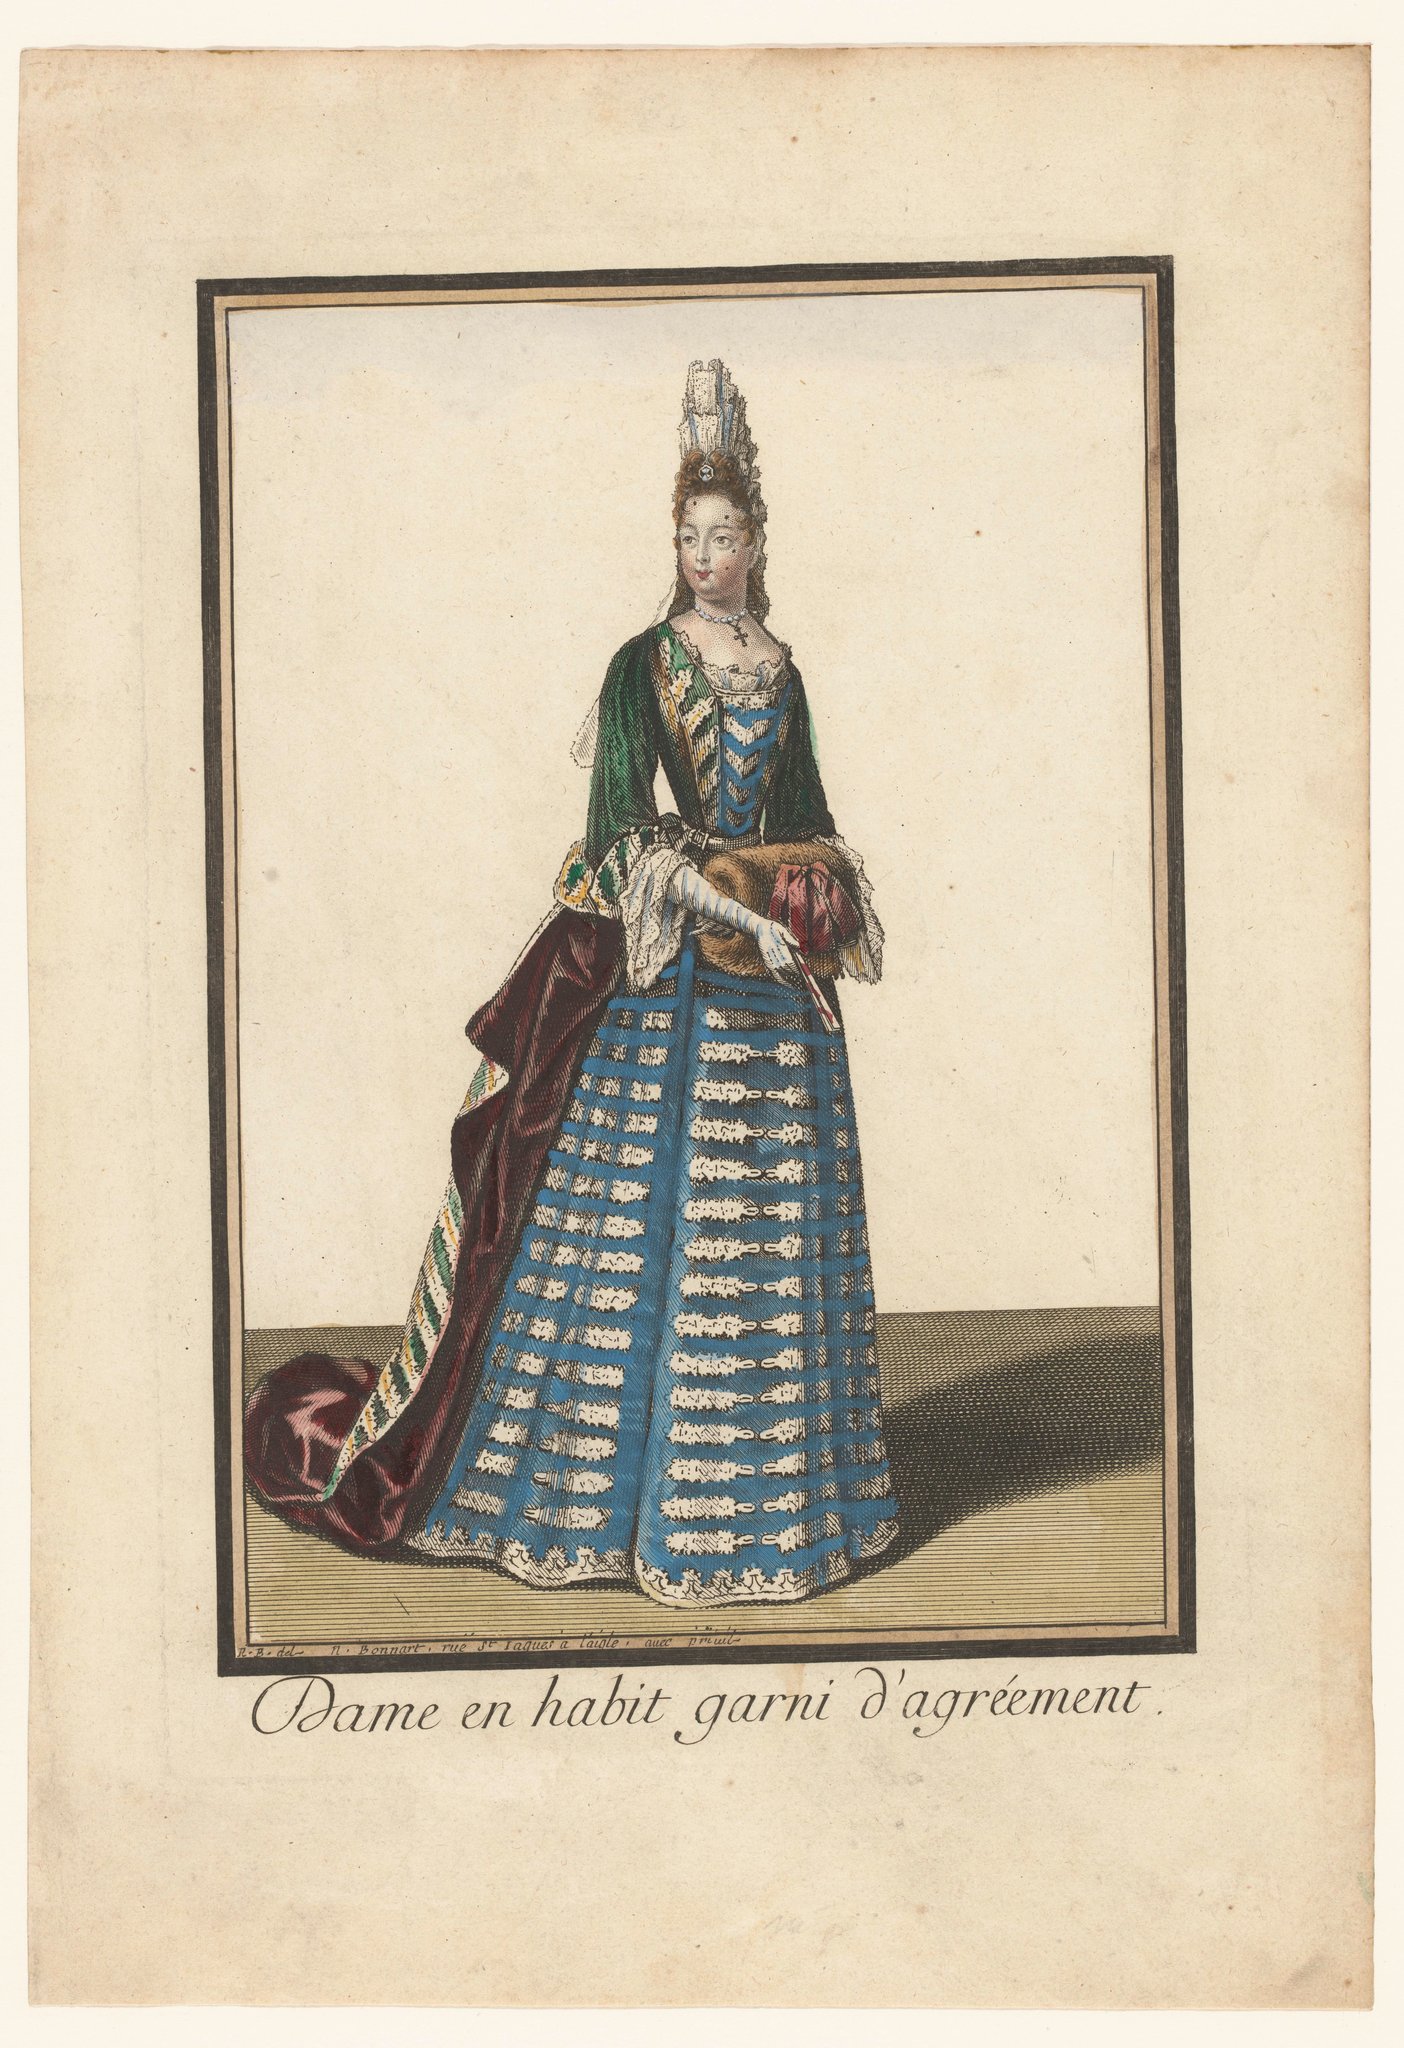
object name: fashion print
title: Dame in blauwe manteau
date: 1685-1690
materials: lacquer, paper, ink, watercolor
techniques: etching, hand coloring, lacquer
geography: paris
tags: pendant, trinket, 'breloque' (+ women's clothes), gloves, mittens (long gloves) (+ women's clothes), fashion plates, head-gear: fontange (+ women's clothes), dress, gown: manteau (+ women's clothes), necklace (+ women's clothes), muff (+ women's clothes)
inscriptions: title (possibly false): ‘Dame en habit garni d’agréement’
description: Dame in blauwe manteau, met sleep, gegarneerd met......., mof om de linkerpols, dichtgevouwen waaier in de rechterhand. Fontangekaspel. Om de hals een ketting met crucifix.